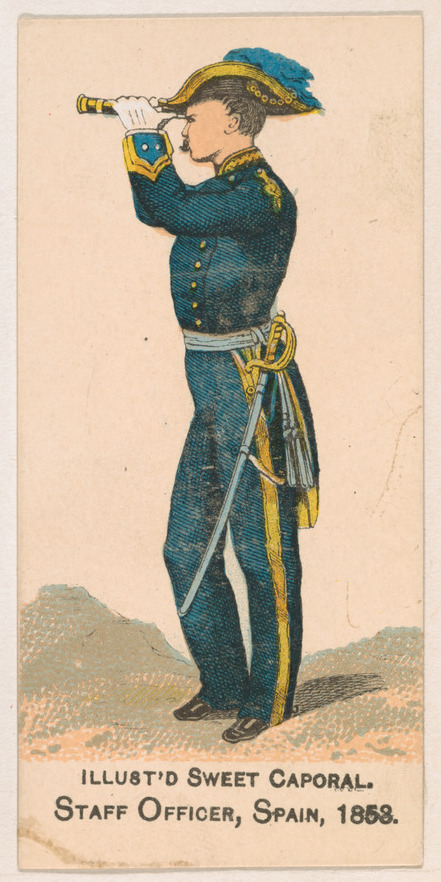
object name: print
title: Staff Officer, Spain, 1853, from the Military Series (N224) issued by Kinney Tobacco Company to promote Sweet Caporal Cigarettes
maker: kinney brothers tobacco company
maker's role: publisher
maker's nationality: american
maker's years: 1869-2011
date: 1888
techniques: color lithograph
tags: soldiers,men,profiles